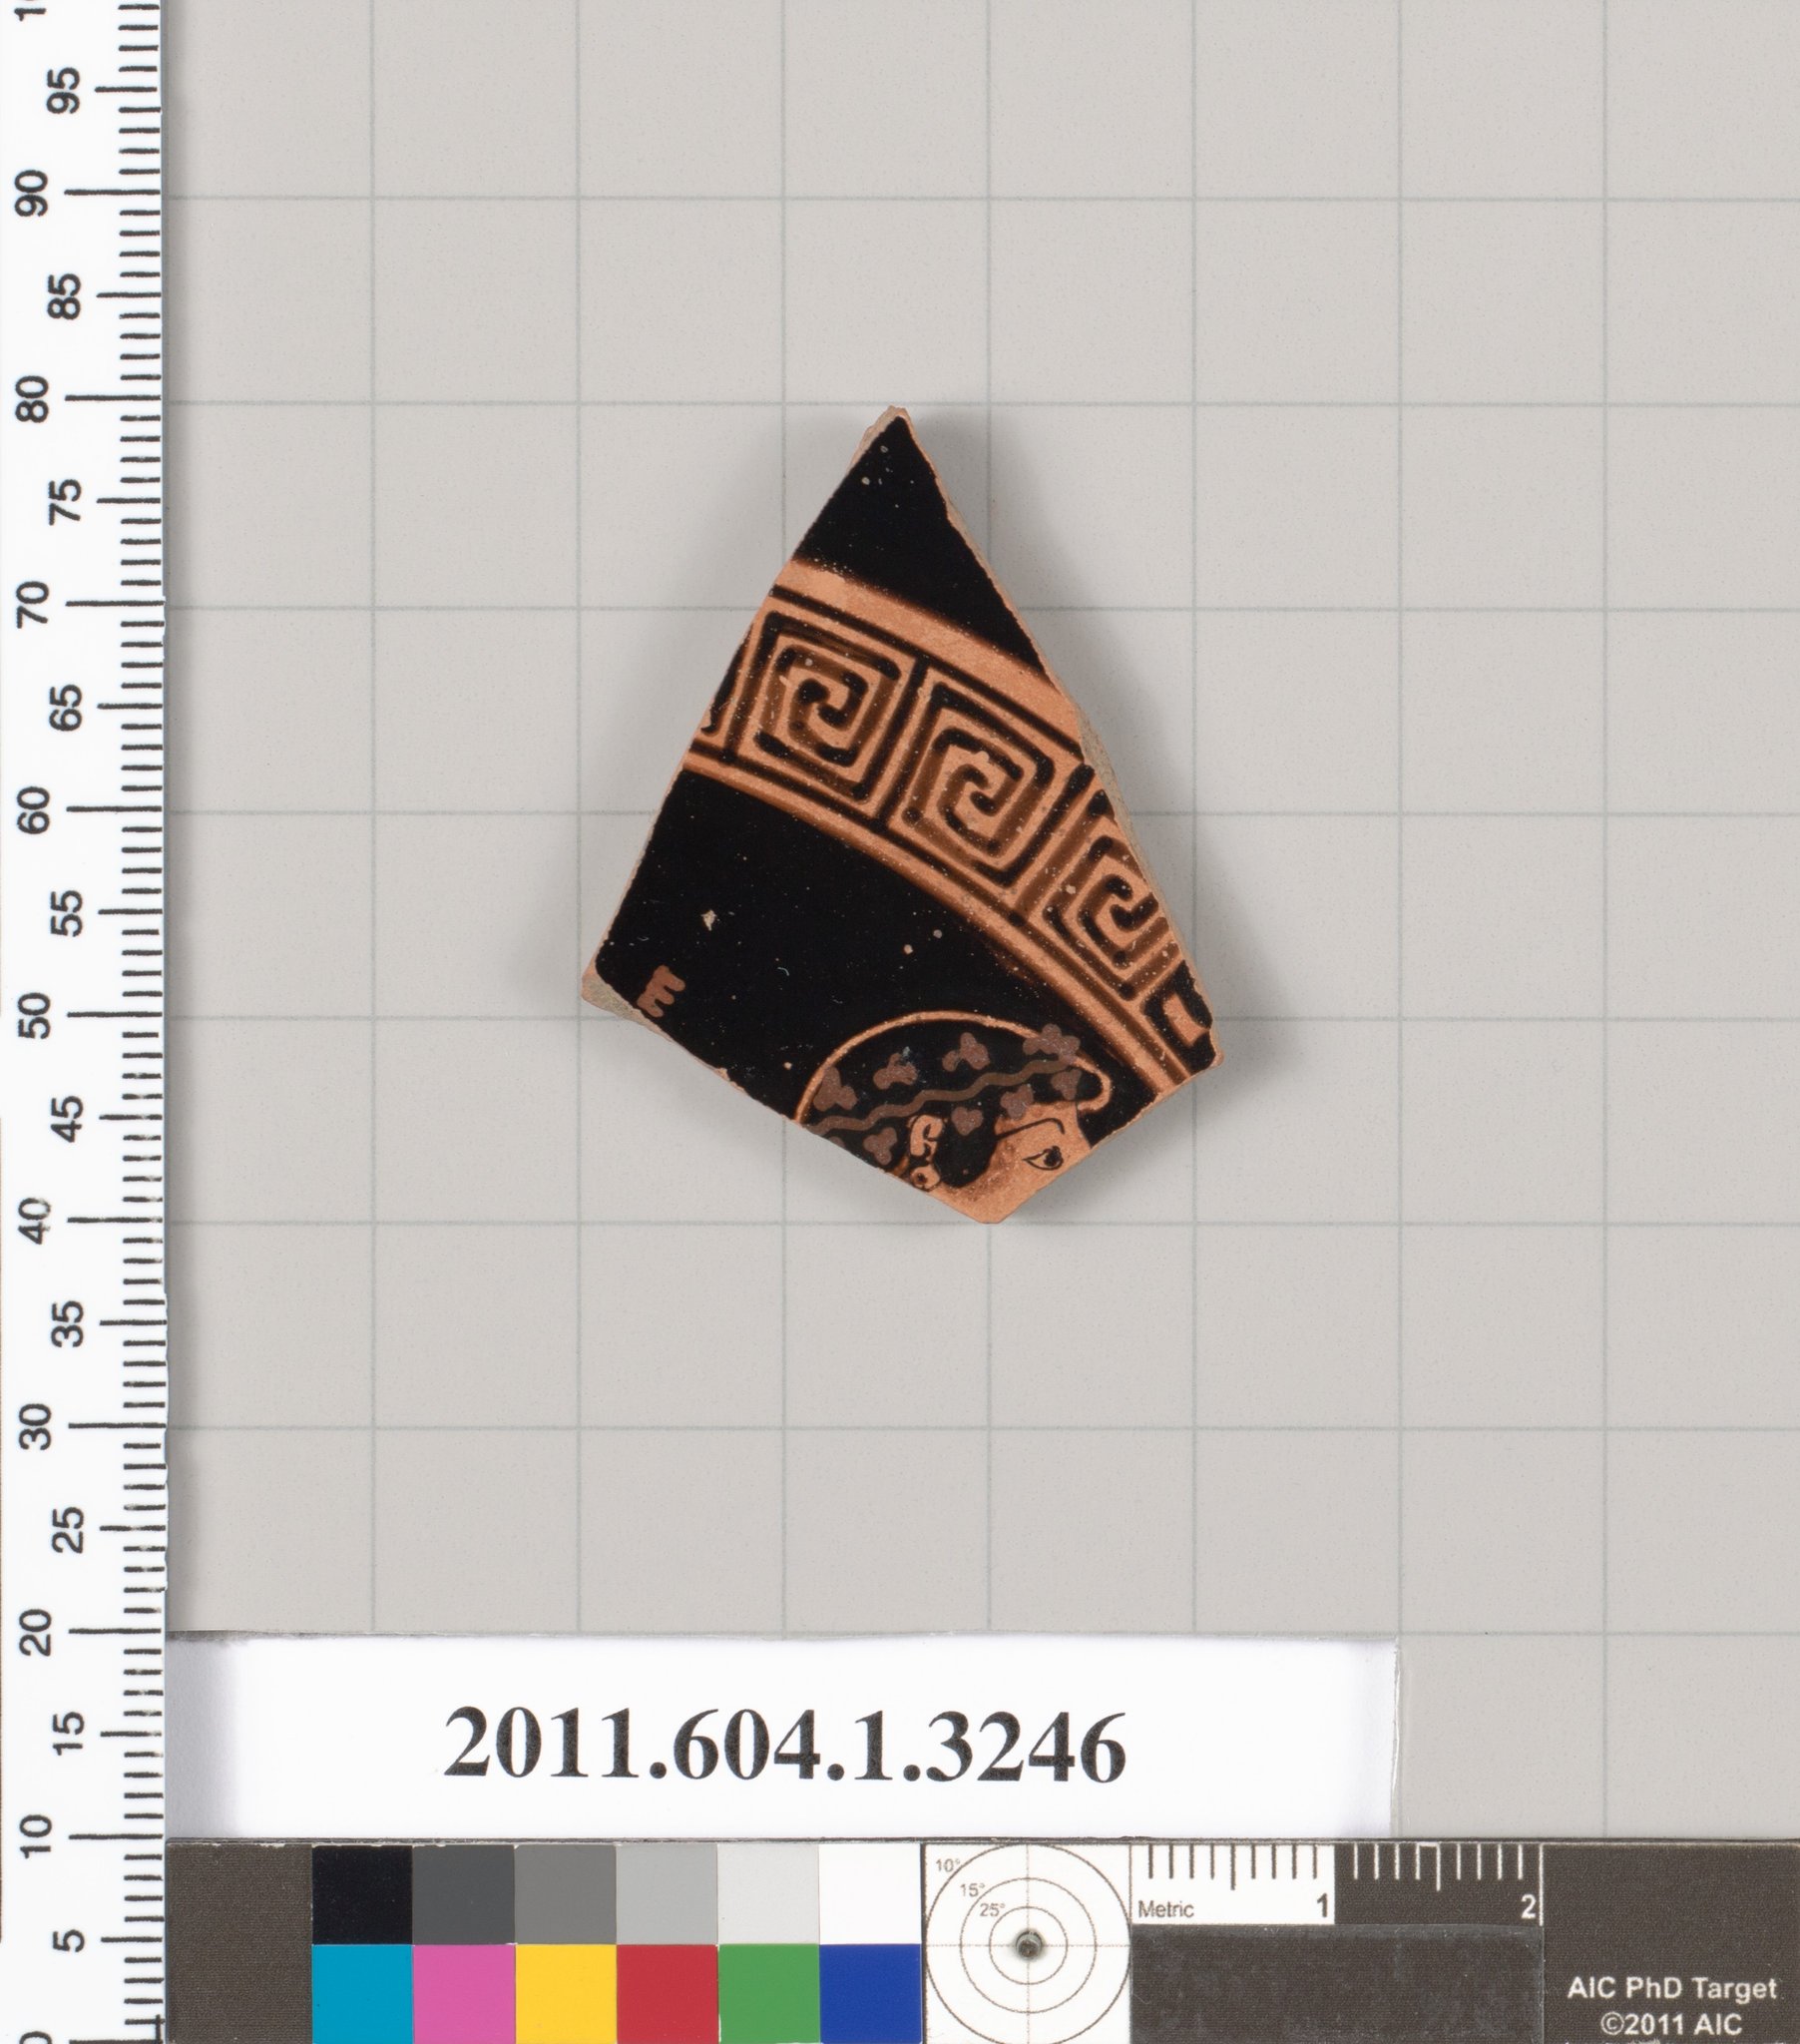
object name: kylix fragment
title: Terracotta fragment of a kylix (drinking cup)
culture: greek, attic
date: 500-480 BCE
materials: terracotta